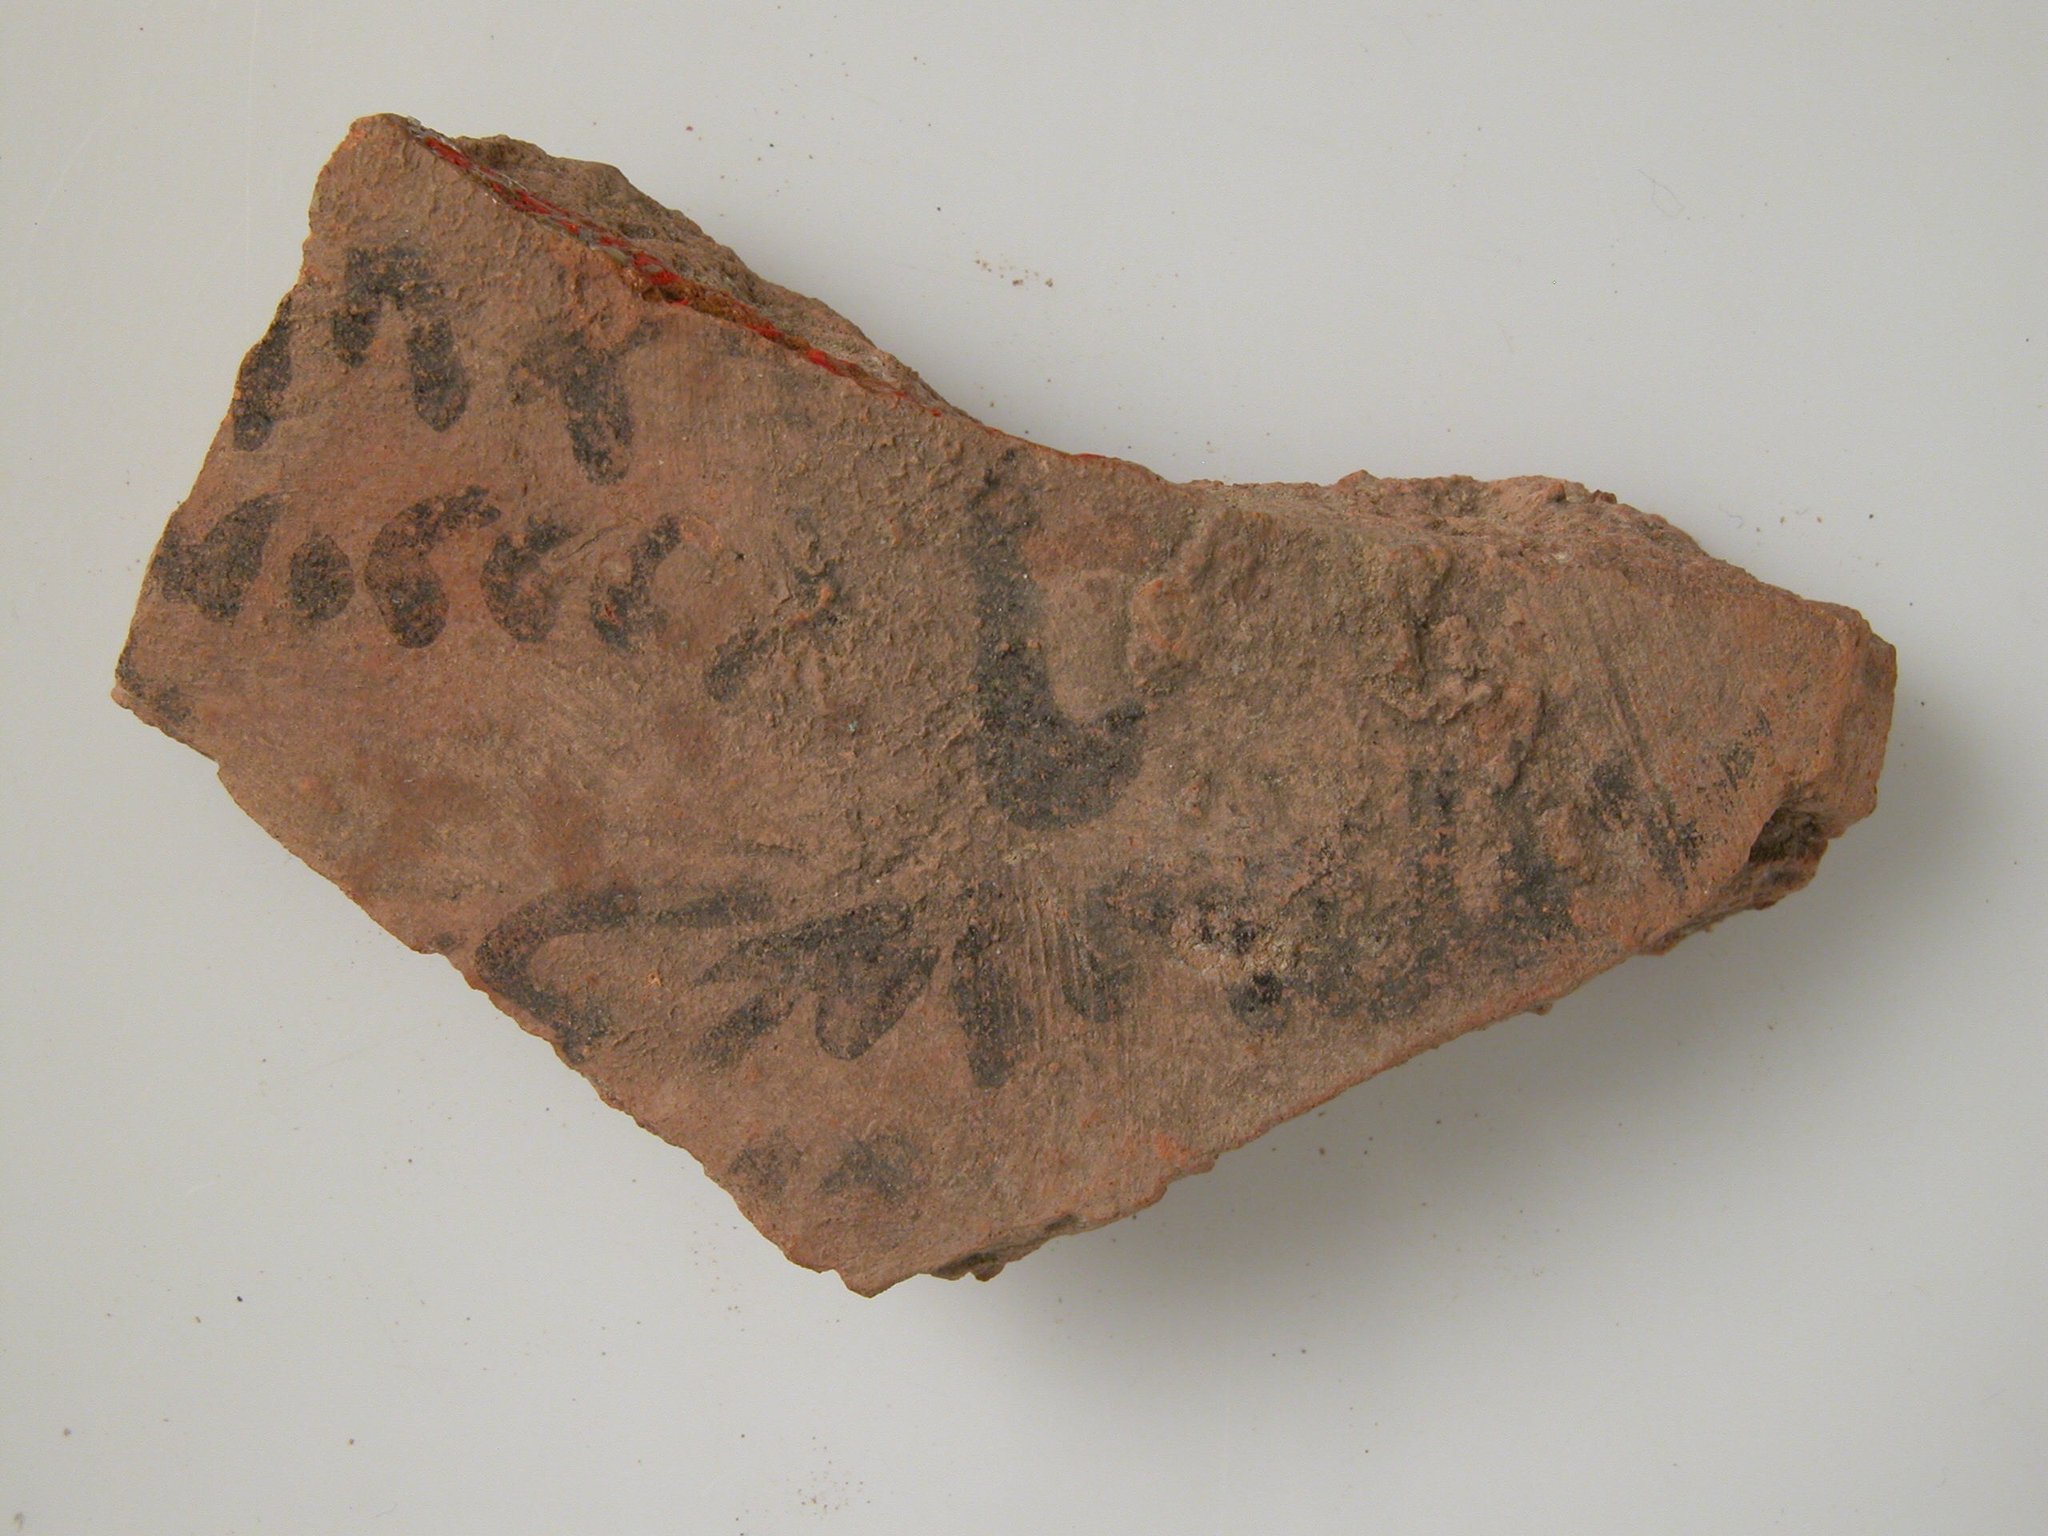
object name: ostracon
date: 400-30 BCE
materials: ink, pottery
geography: egypt